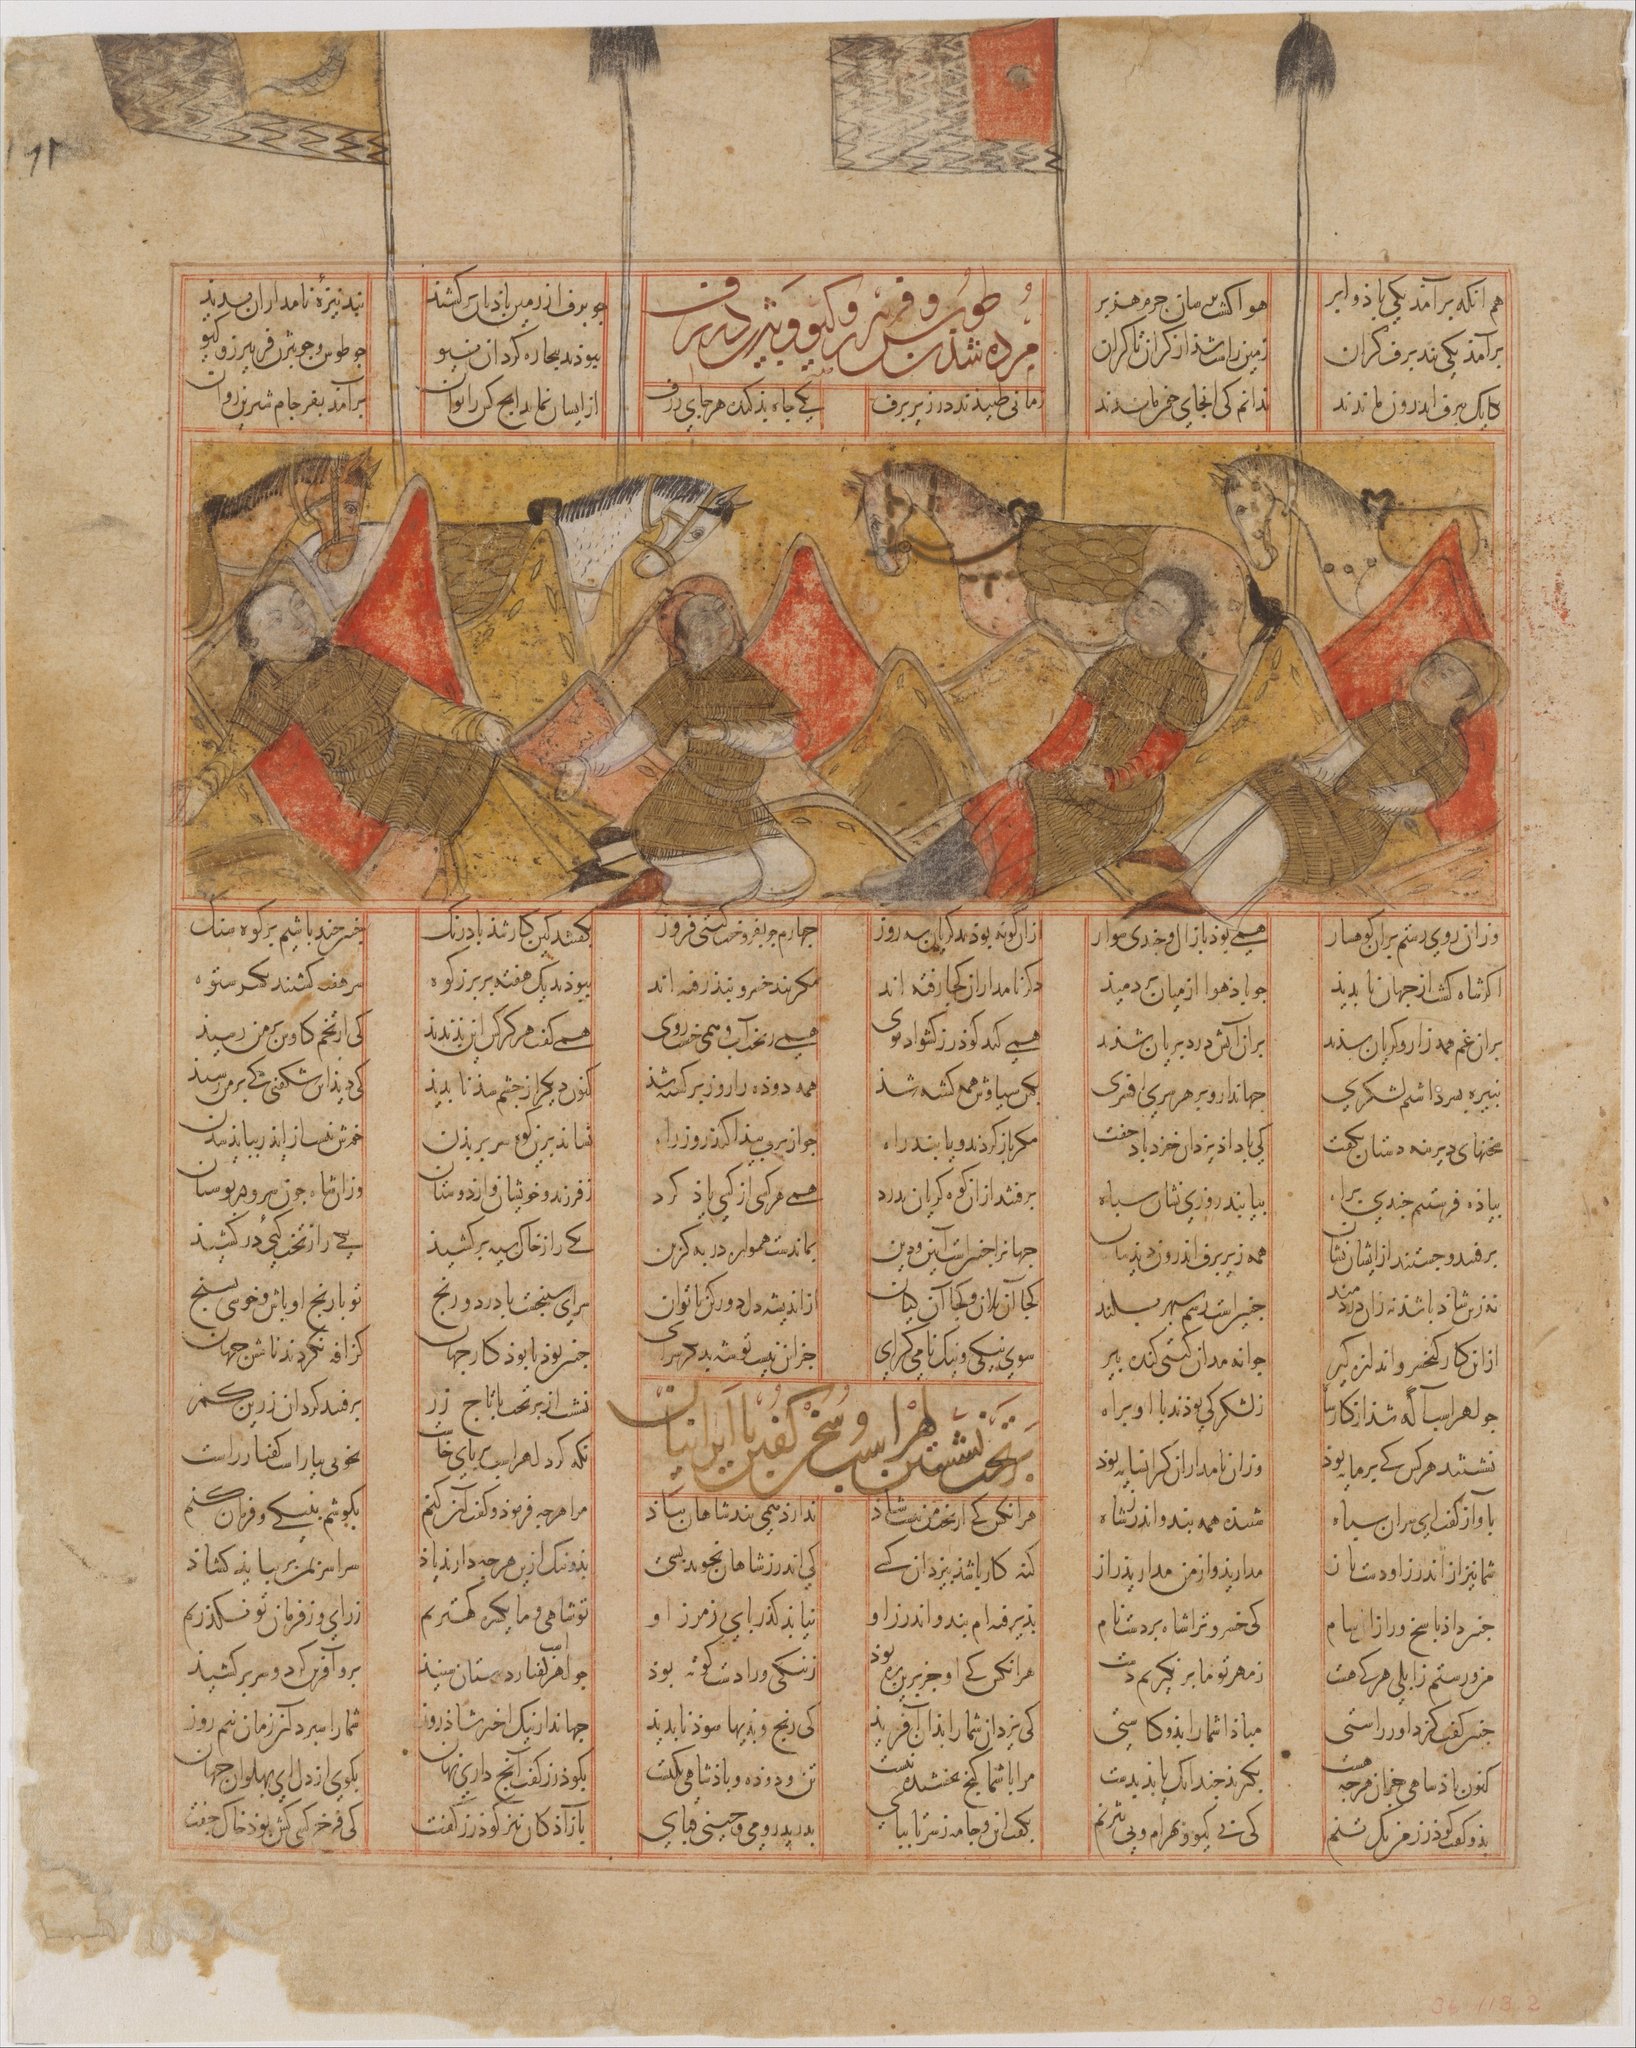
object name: folio from an illustrated manuscript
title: "The Four Knights of Kai Khusrau in the Mountains", Folio from a Shahnama (Book of Kings)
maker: abu'l qasim firdausi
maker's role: author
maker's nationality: iranian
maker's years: 935-1020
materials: gold, ink, paper, watercolor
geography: iran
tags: men,horses,knights